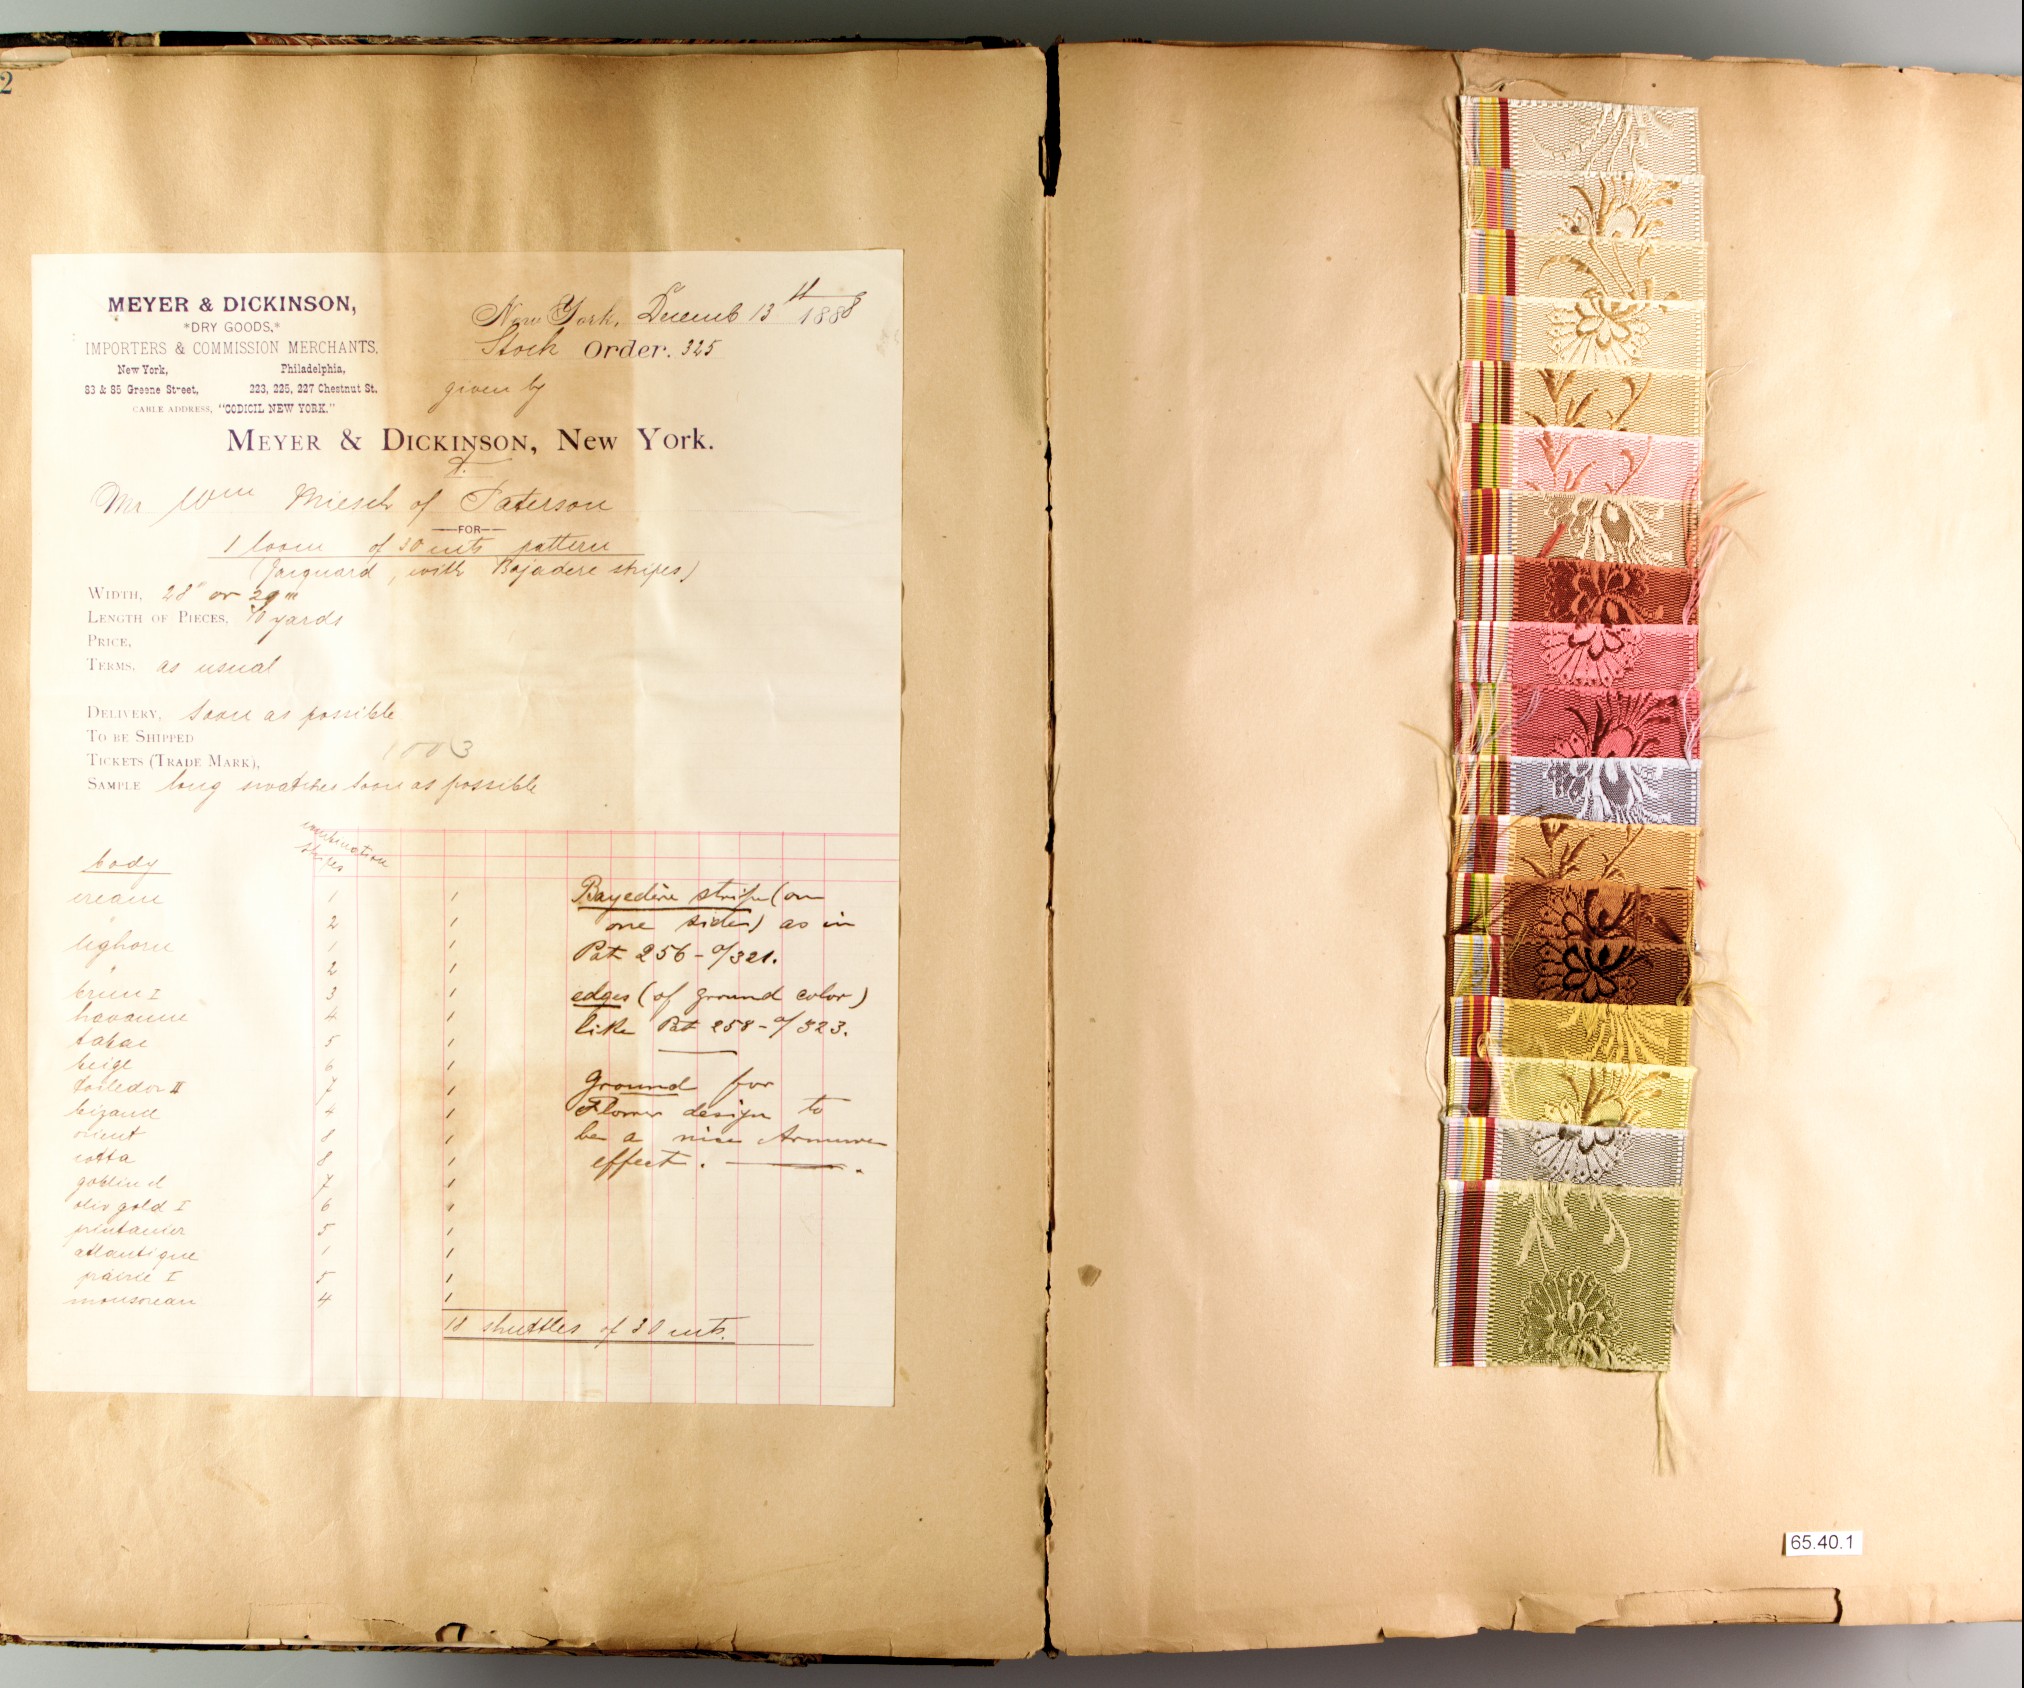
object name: sample book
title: Textile sample book of ribbons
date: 1888-1890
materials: silk